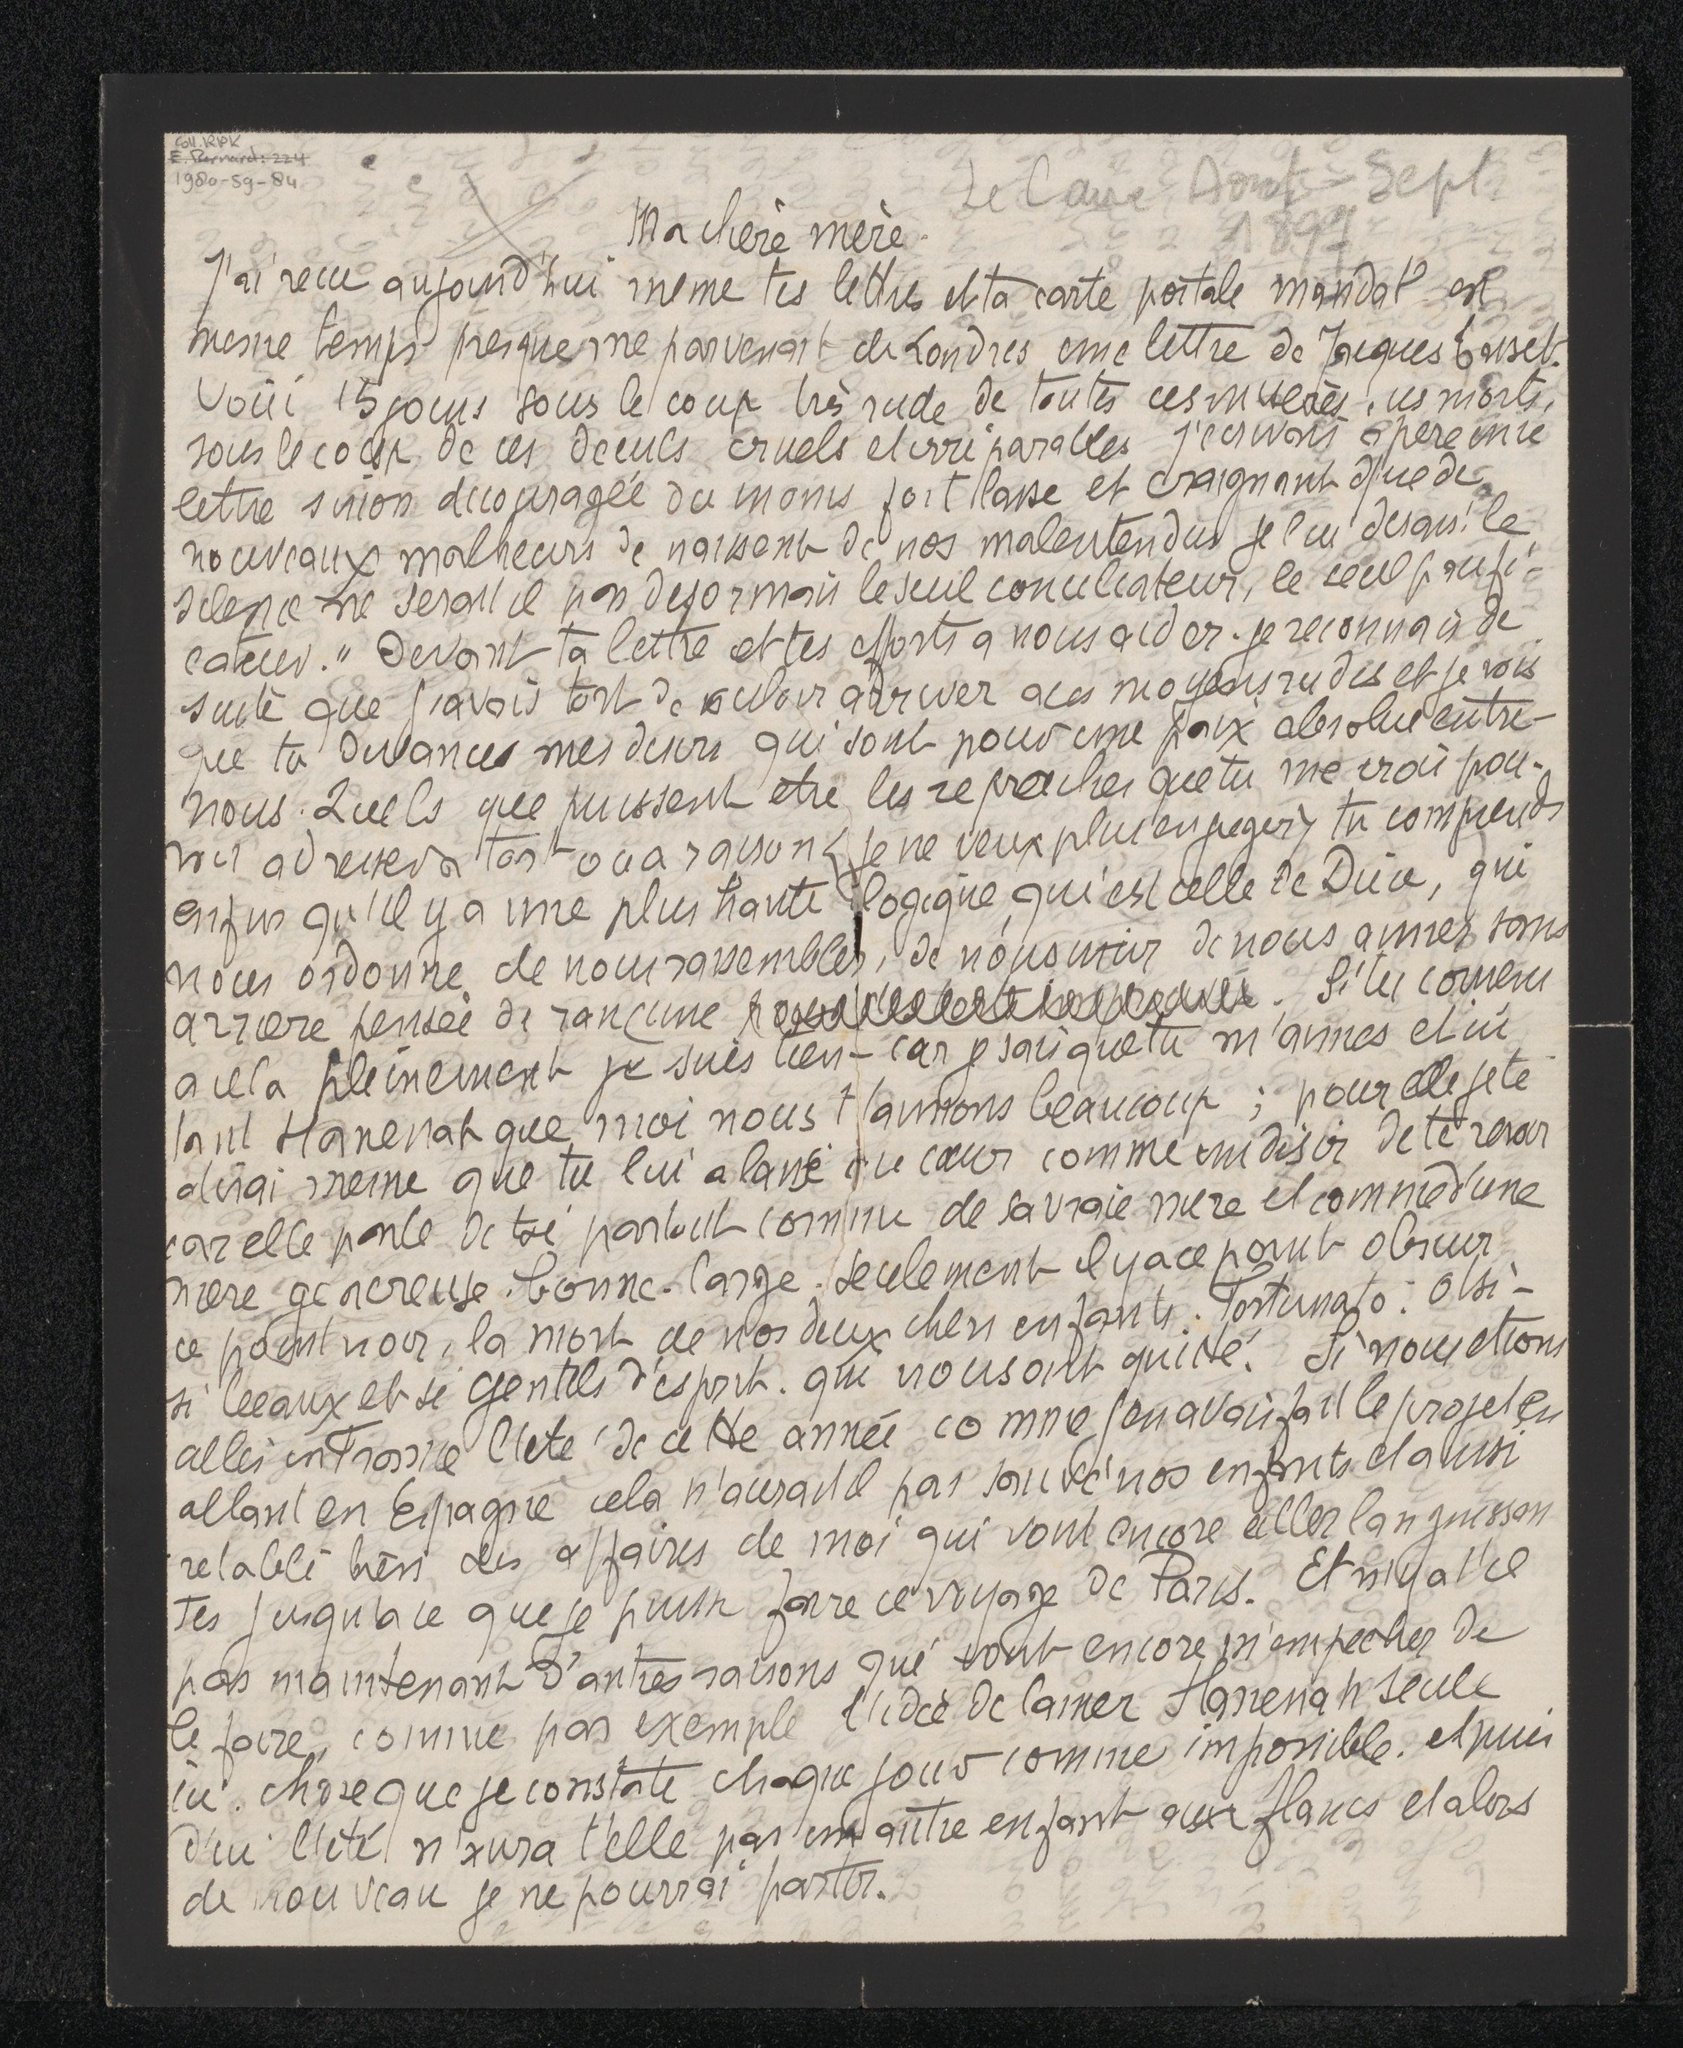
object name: letter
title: Brief aan Héloïse Bernard-Bodin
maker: émile bernard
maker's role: print maker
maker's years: 1868-1941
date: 1809-1897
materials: ink, paper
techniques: pen, writing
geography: cairo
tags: héloïse bernard-bodin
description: Brief gedateerd Aout-Sept 1897 in latere hand.